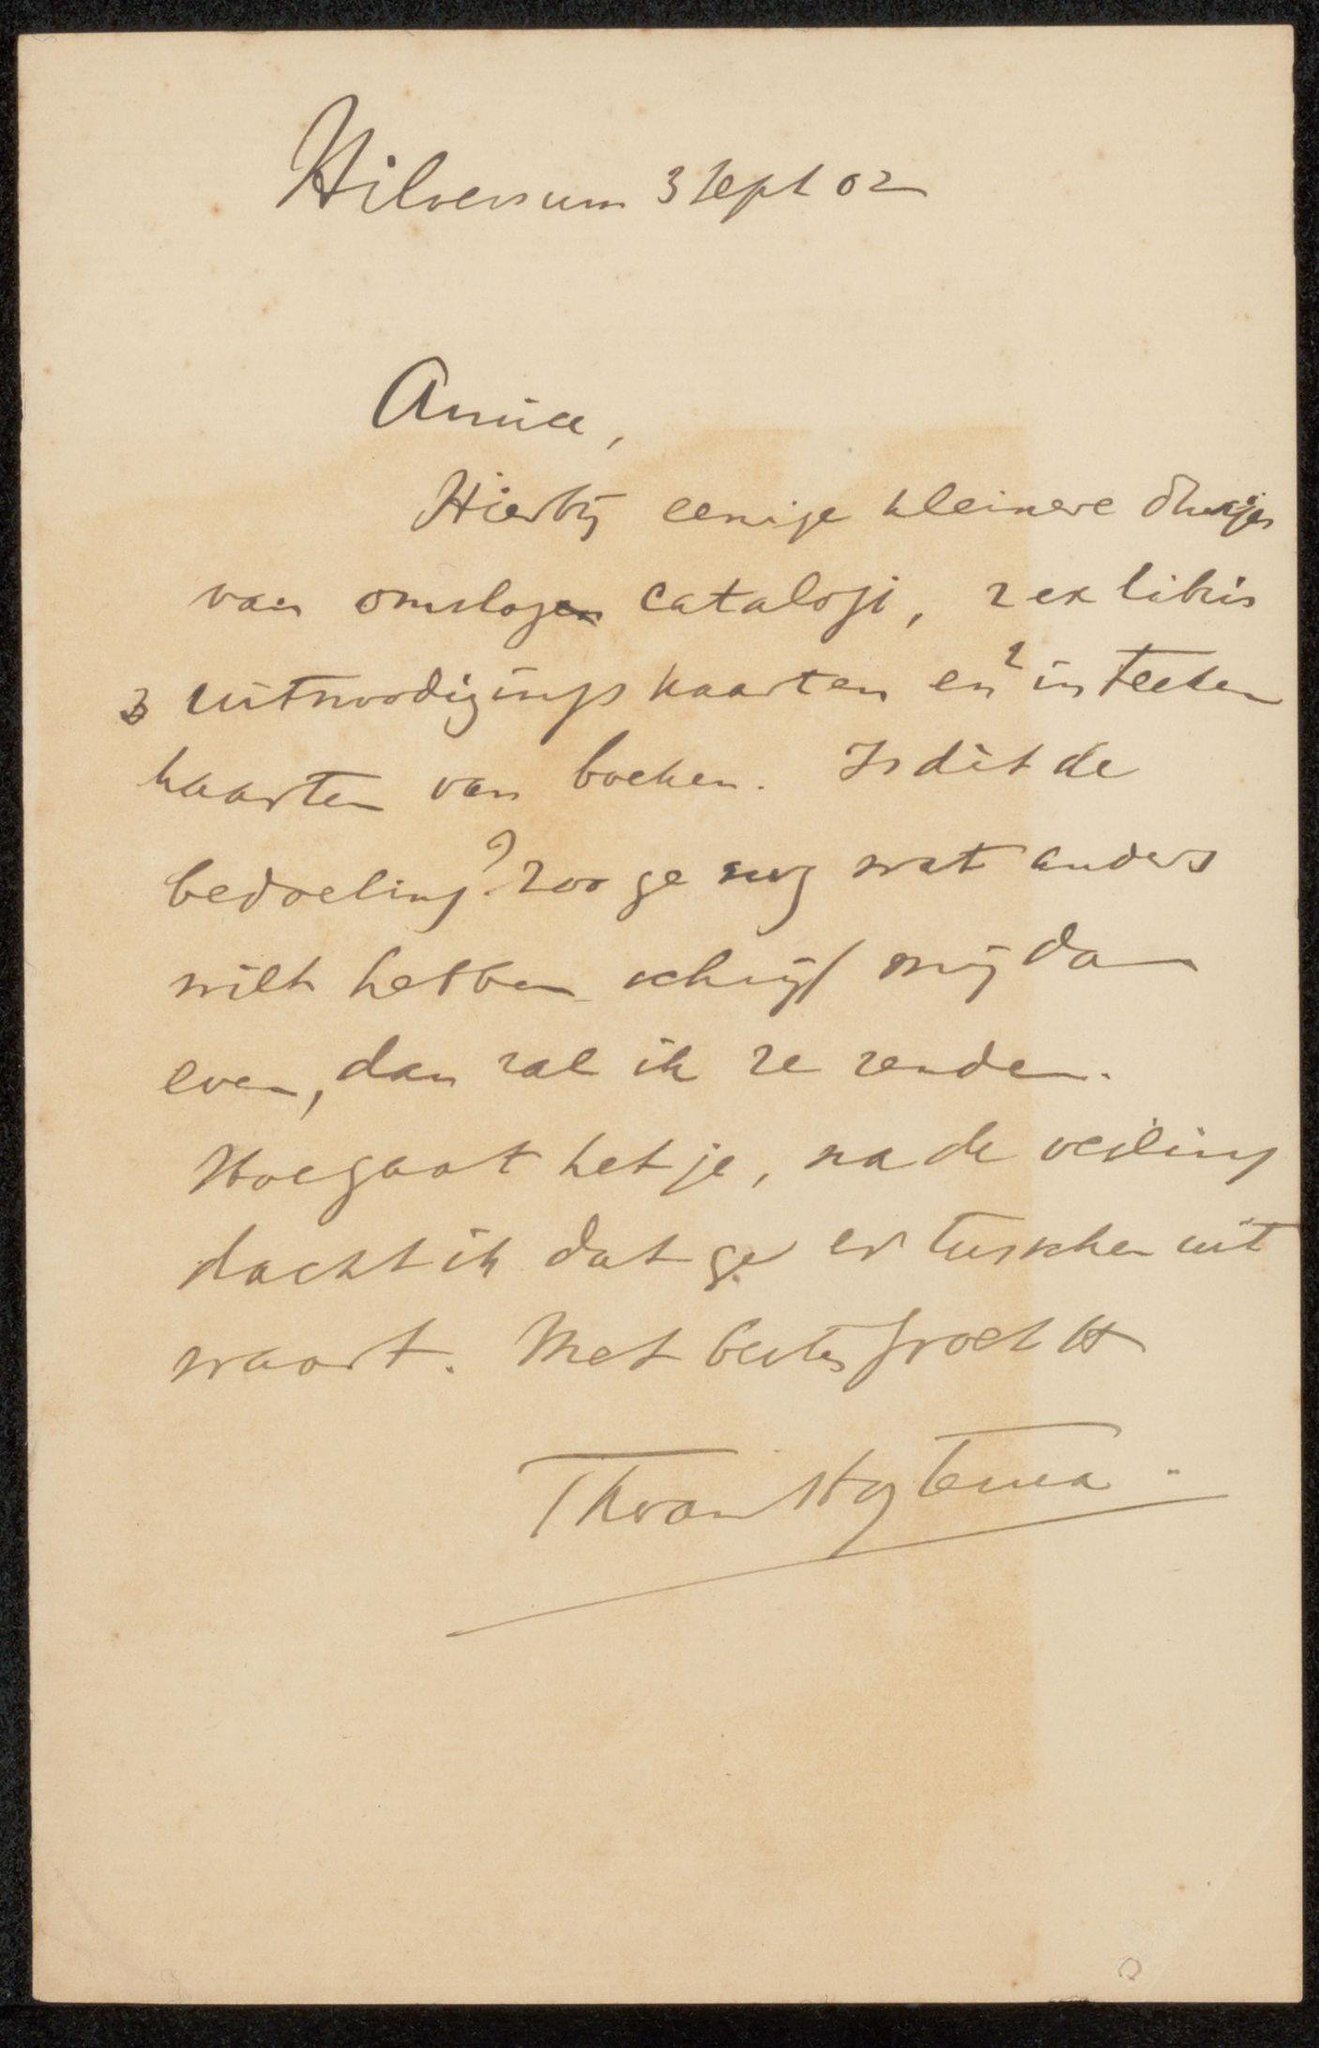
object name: letter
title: Brief aan Philip Zilcken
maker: theo van hoytema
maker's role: draughtsman, painter, print maker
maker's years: 1863-1917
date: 1902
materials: ink, paper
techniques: pen, writing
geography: hilversum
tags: rotterdam, amsterdam, herman robbers, philip zilcken, the graphic arts, printed matter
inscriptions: collector's mark: ‘RPK’